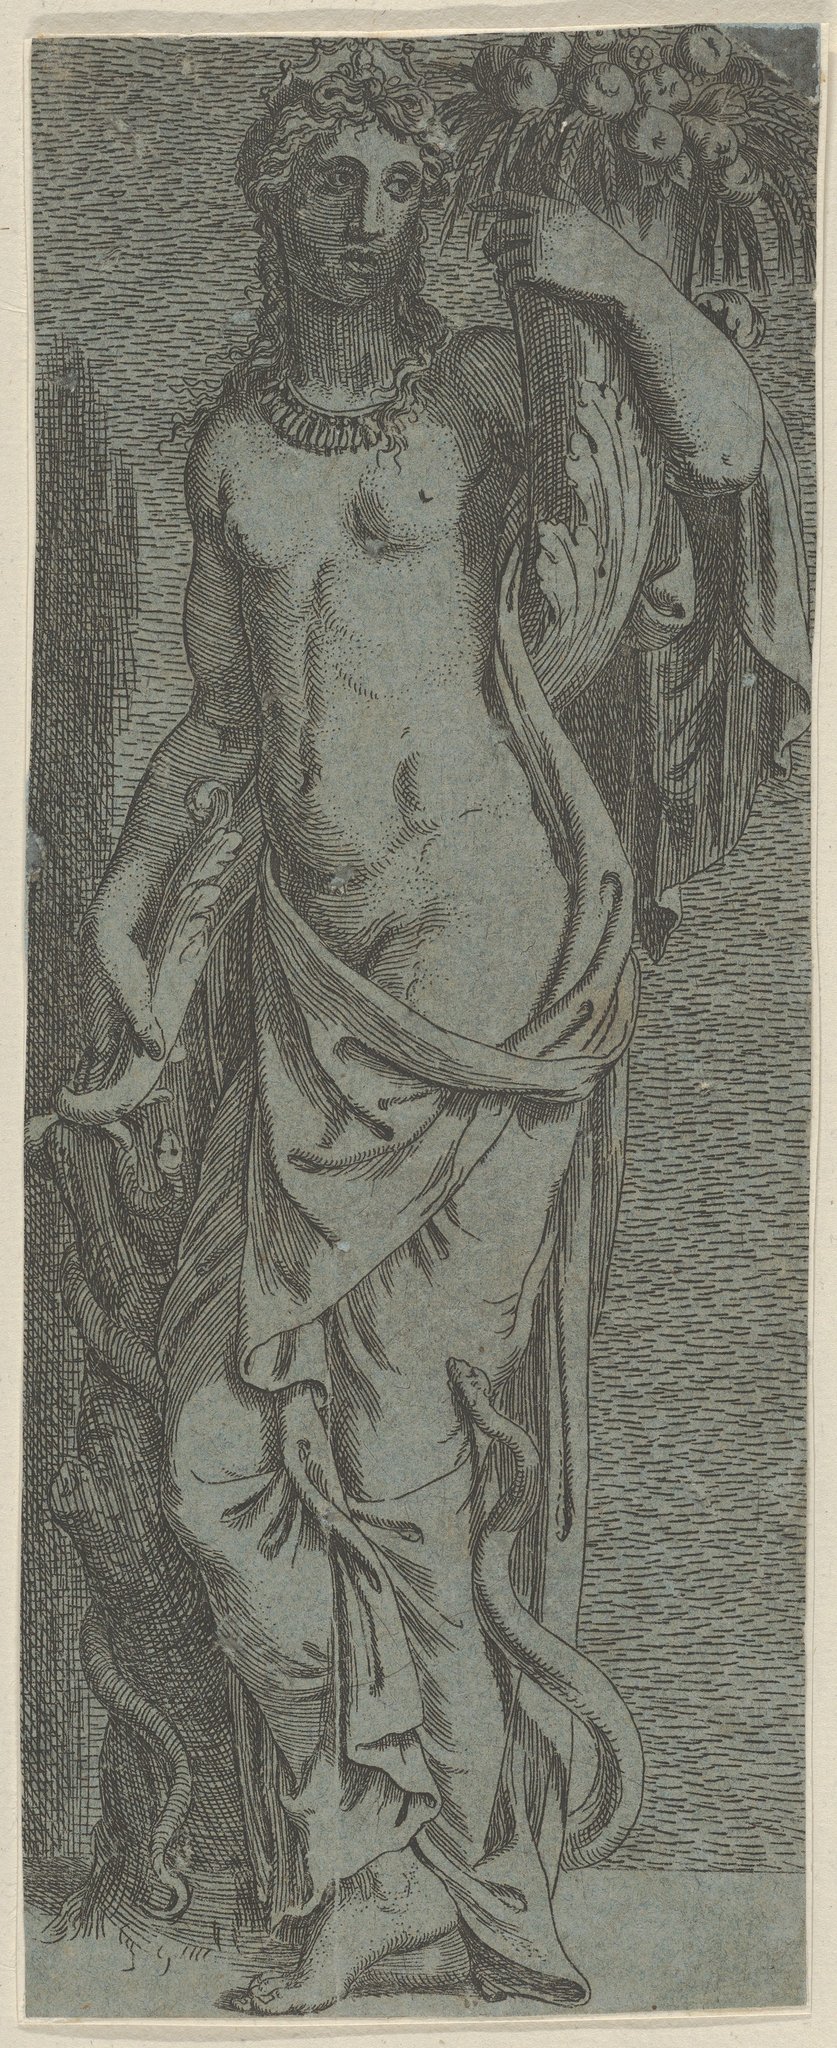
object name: print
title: Summer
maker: battista angolo del moro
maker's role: artist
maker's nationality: italian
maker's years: 1515-1573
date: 1530-1573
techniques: etching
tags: female nudes,cornucopia